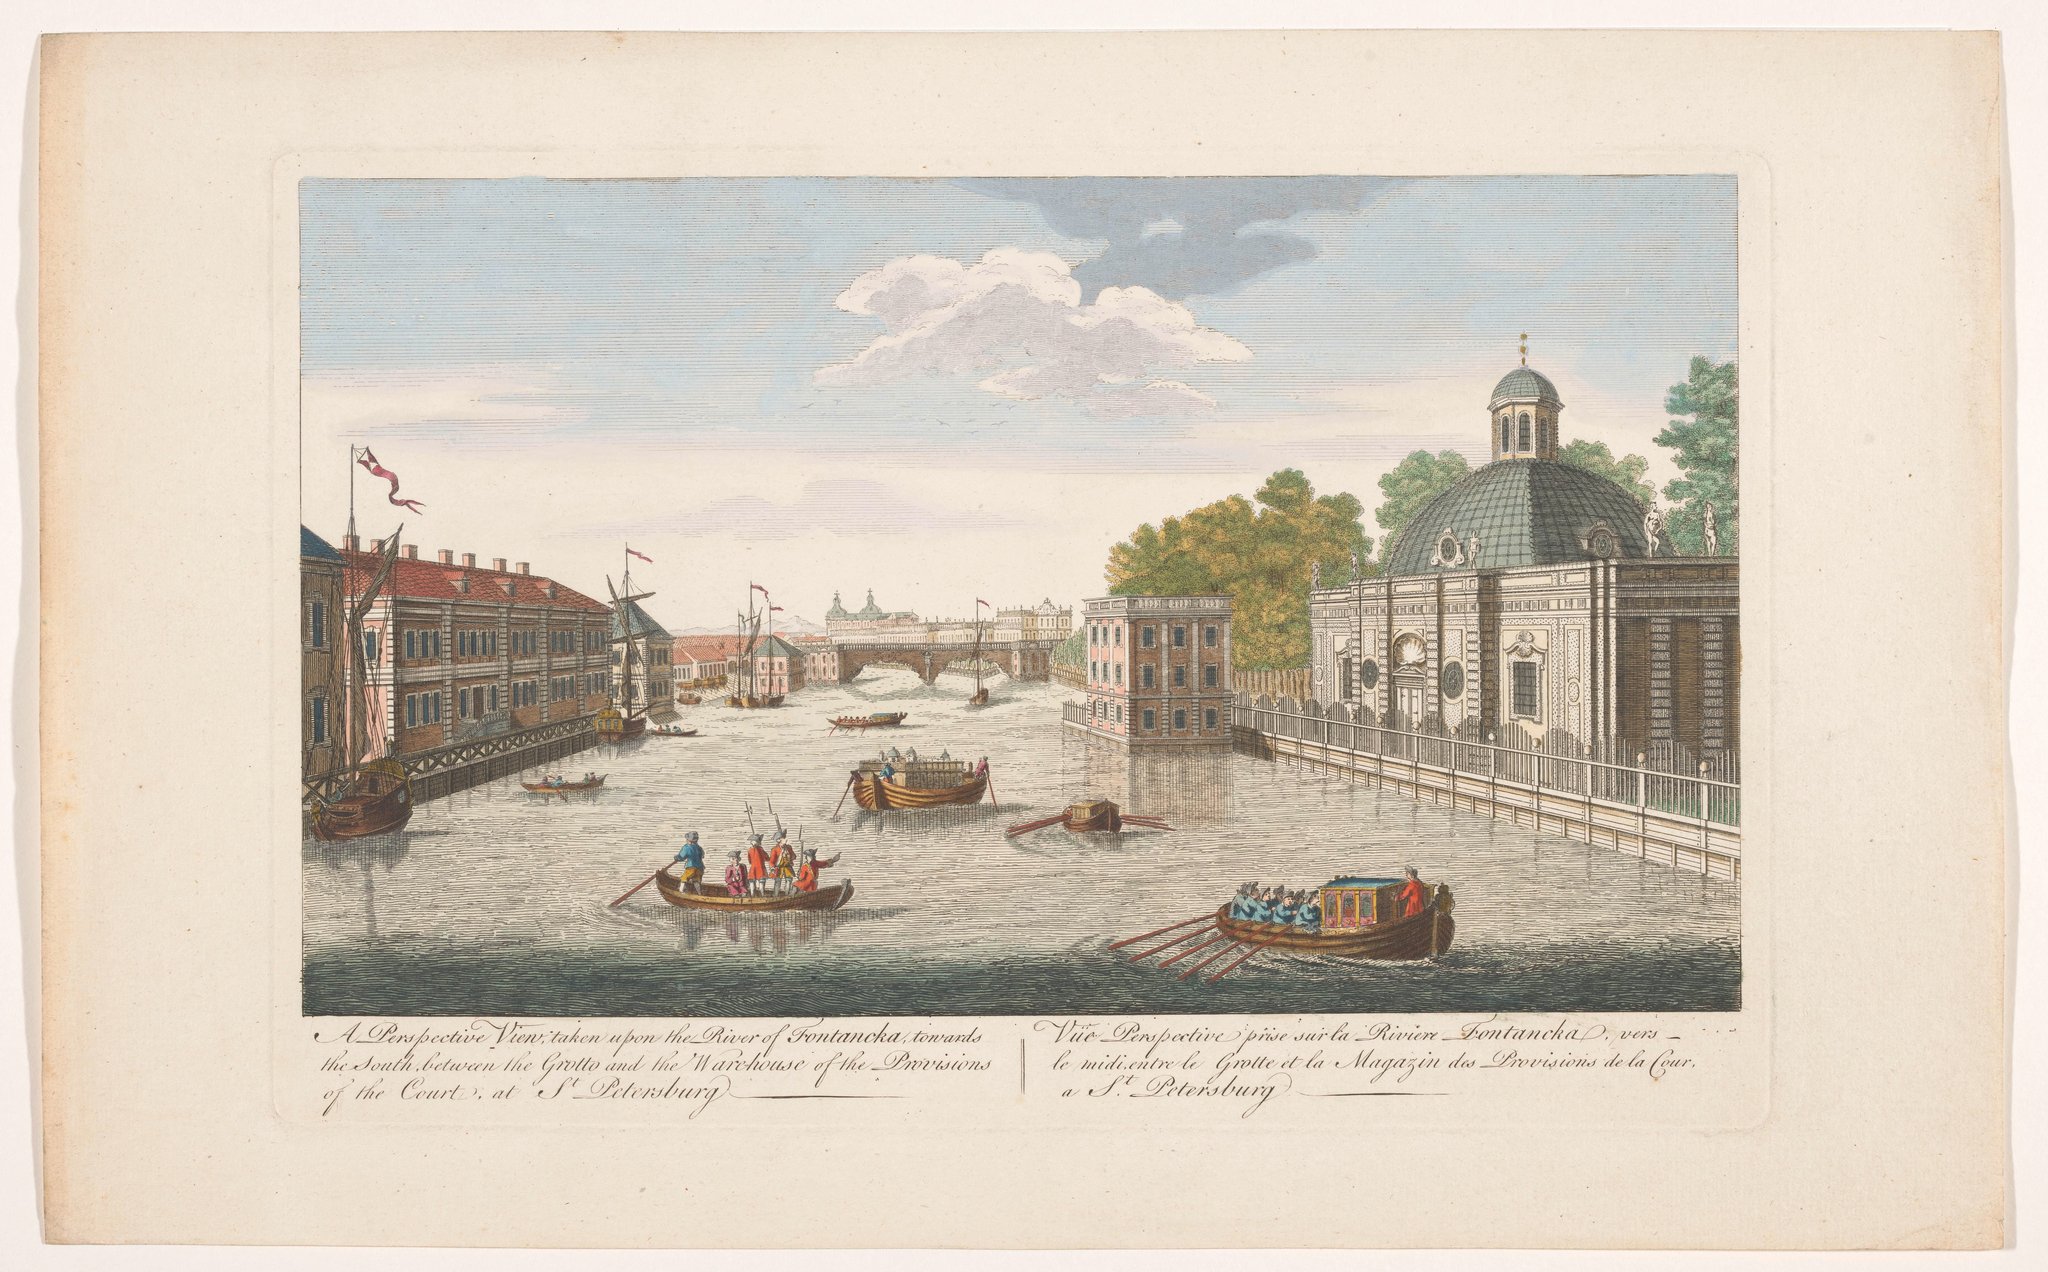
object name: opticaprent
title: A perspective view, taken upon the river of Fontancka, towards the south (...)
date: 1745-1794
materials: paper, watercolor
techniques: brush, etching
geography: england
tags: bridge in city across river, canal, etc. (+ city(-scape) with figures, staffage), sailing-ship, sailing-boat, rowing-boat, canoe, etc., civic architecture; edifices; dwellings